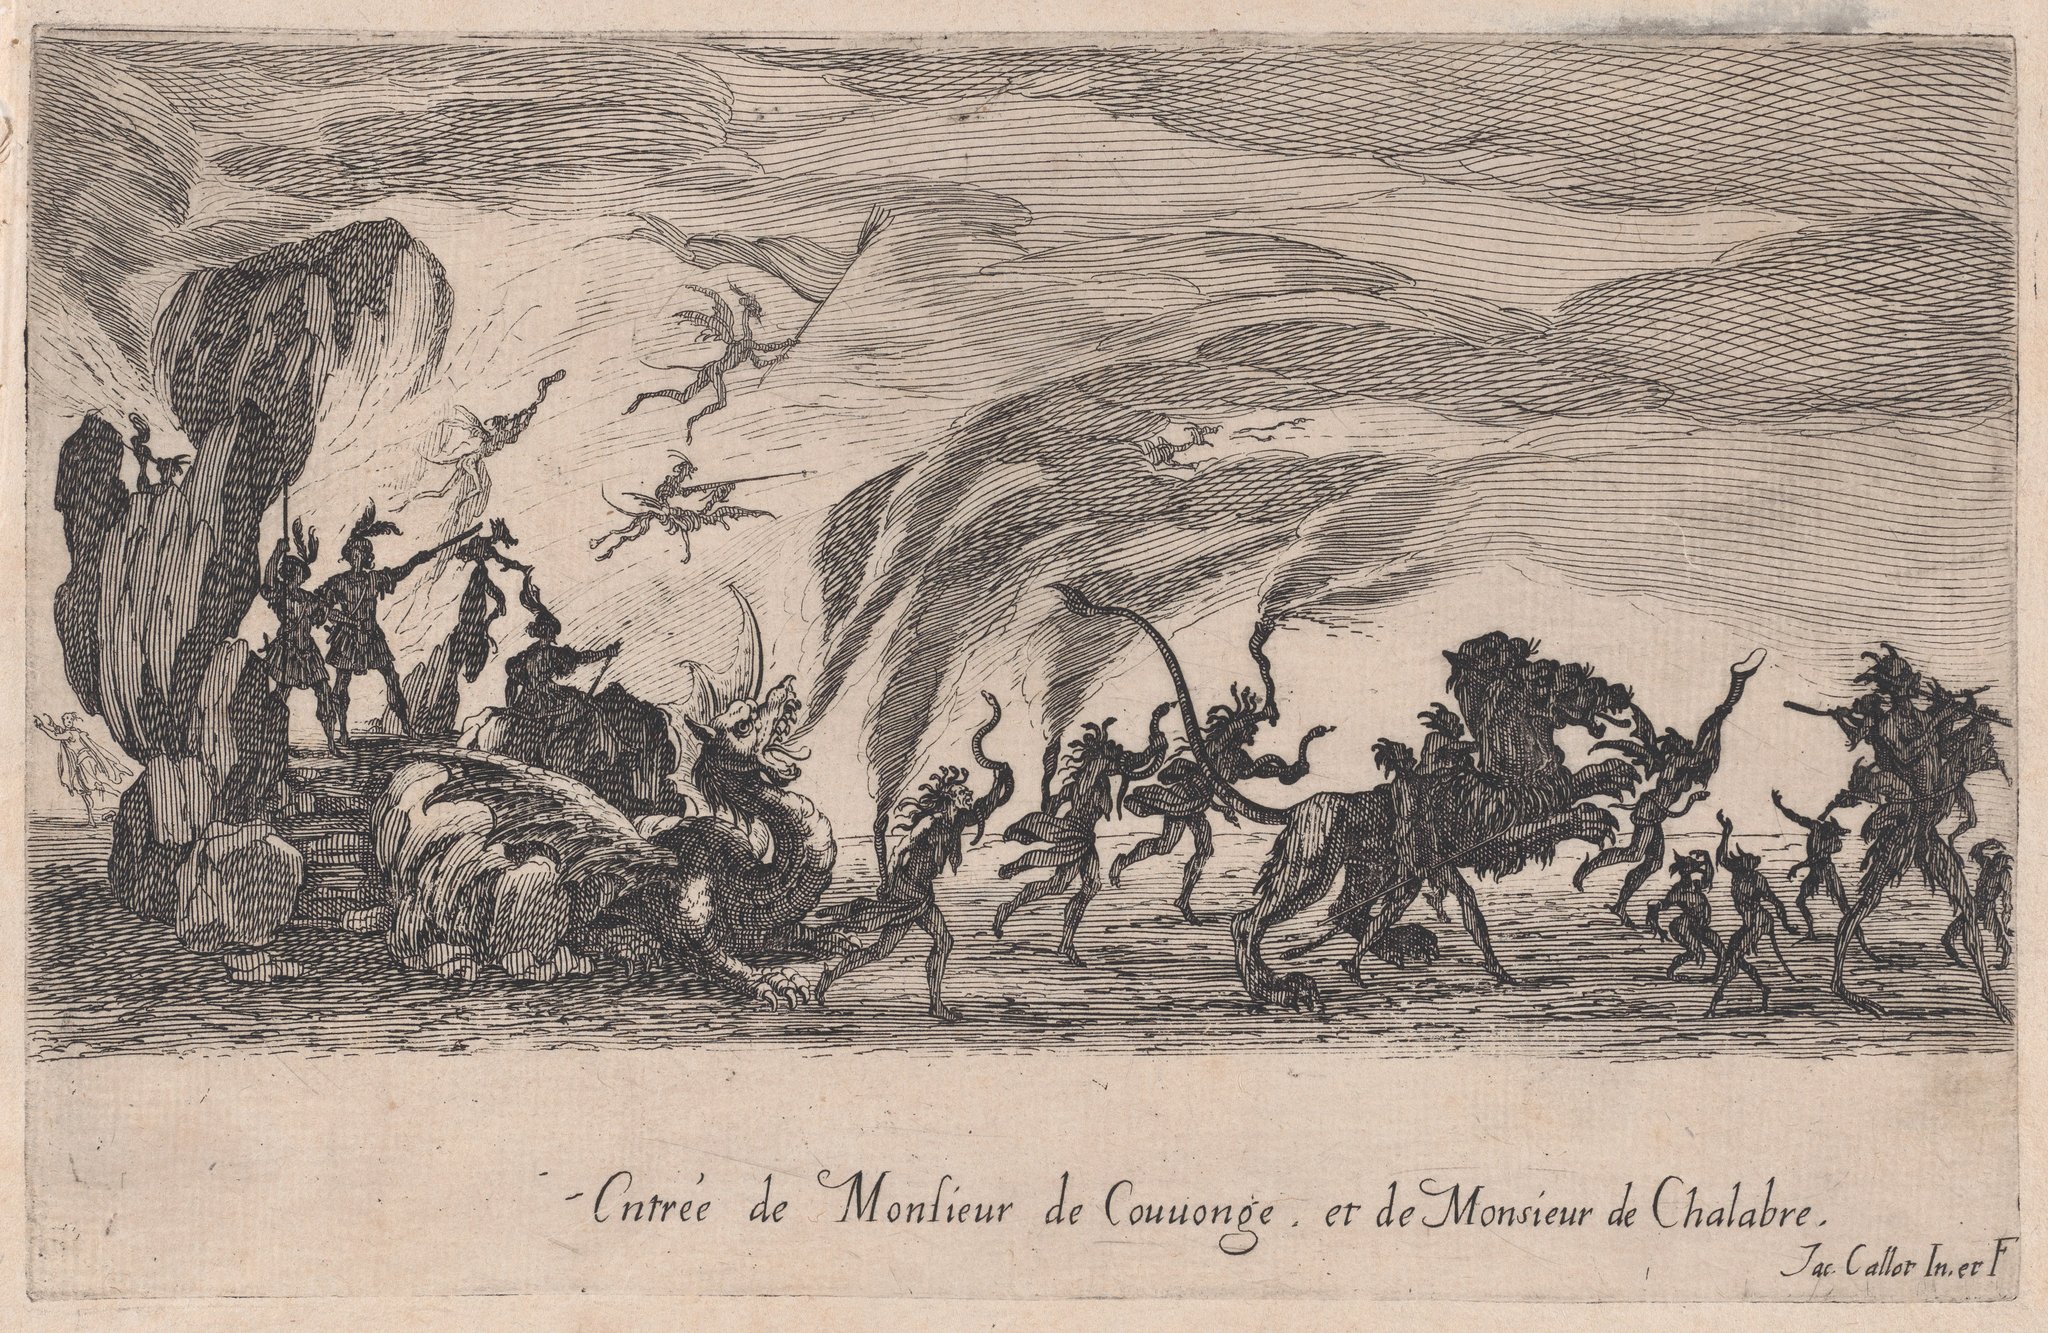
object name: print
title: Entrée de MM. de Couvonge et de Chalabre (Entrance of Monsieur du Couvonge and of Monsieur de Chalabre), from Le Combat a la Barrière in the Palace at Nancy by Henri Humbert, printed by Sebastien Phillipe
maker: jacques callot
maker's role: artist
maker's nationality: french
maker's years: 1592-1635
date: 1627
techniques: etching